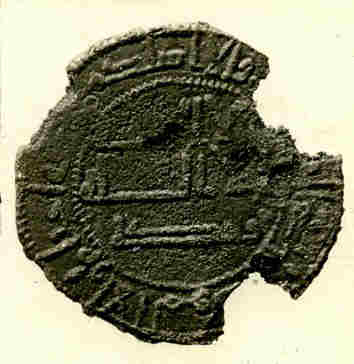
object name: coin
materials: copper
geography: iran